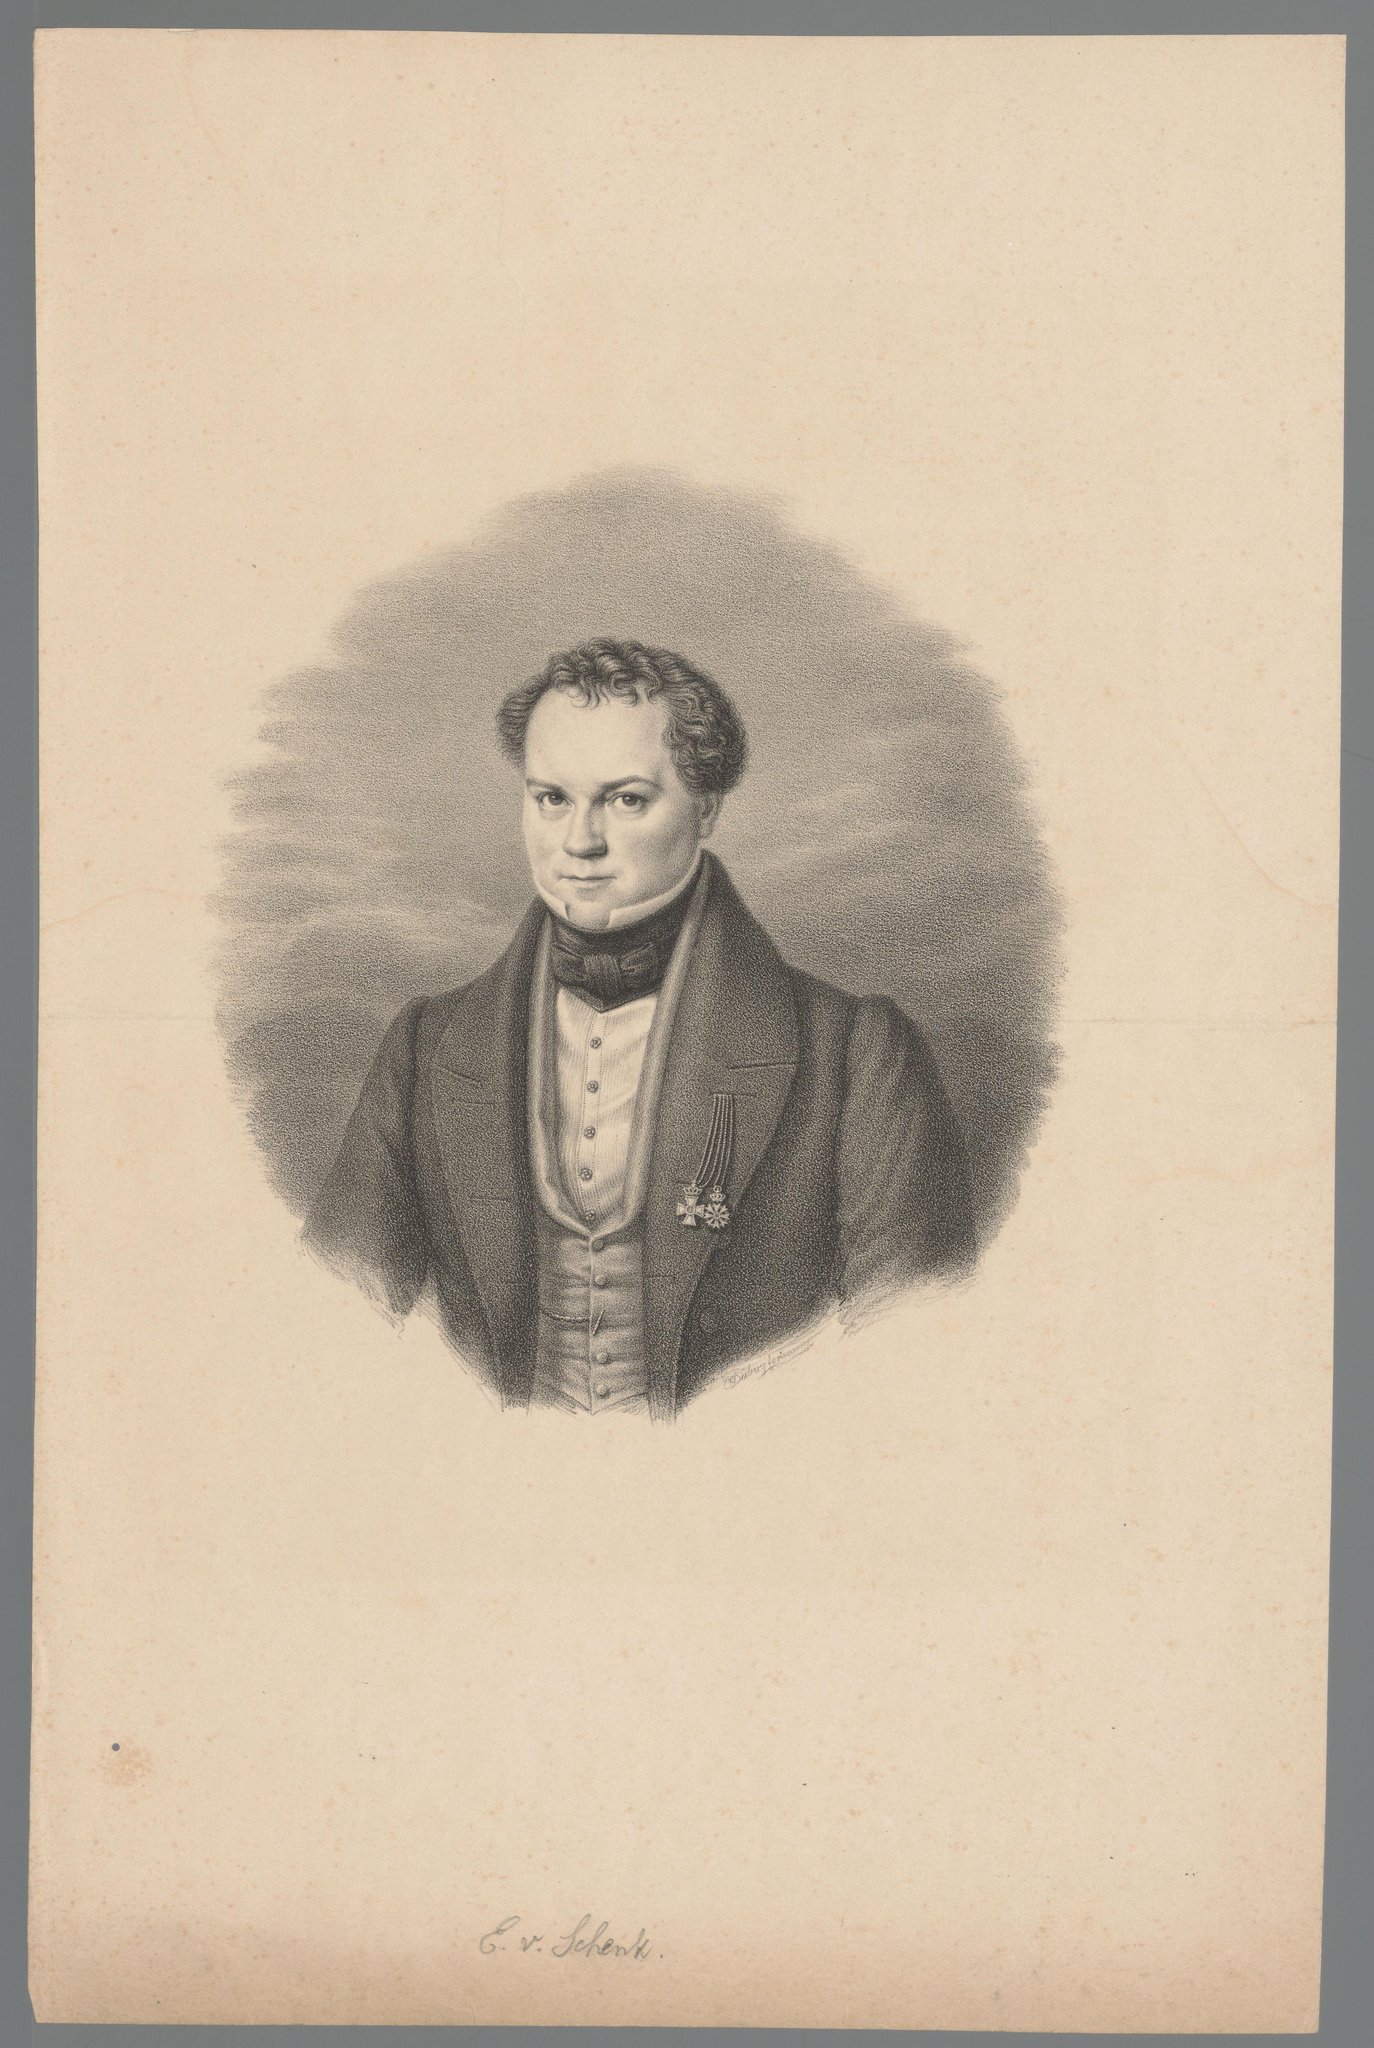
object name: print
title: Portret van een onbekende man, mogelijk E. van Schenk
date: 1820-1850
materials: paper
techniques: lithograph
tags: adult man, historical persons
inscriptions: collector's mark: Lugt 2228